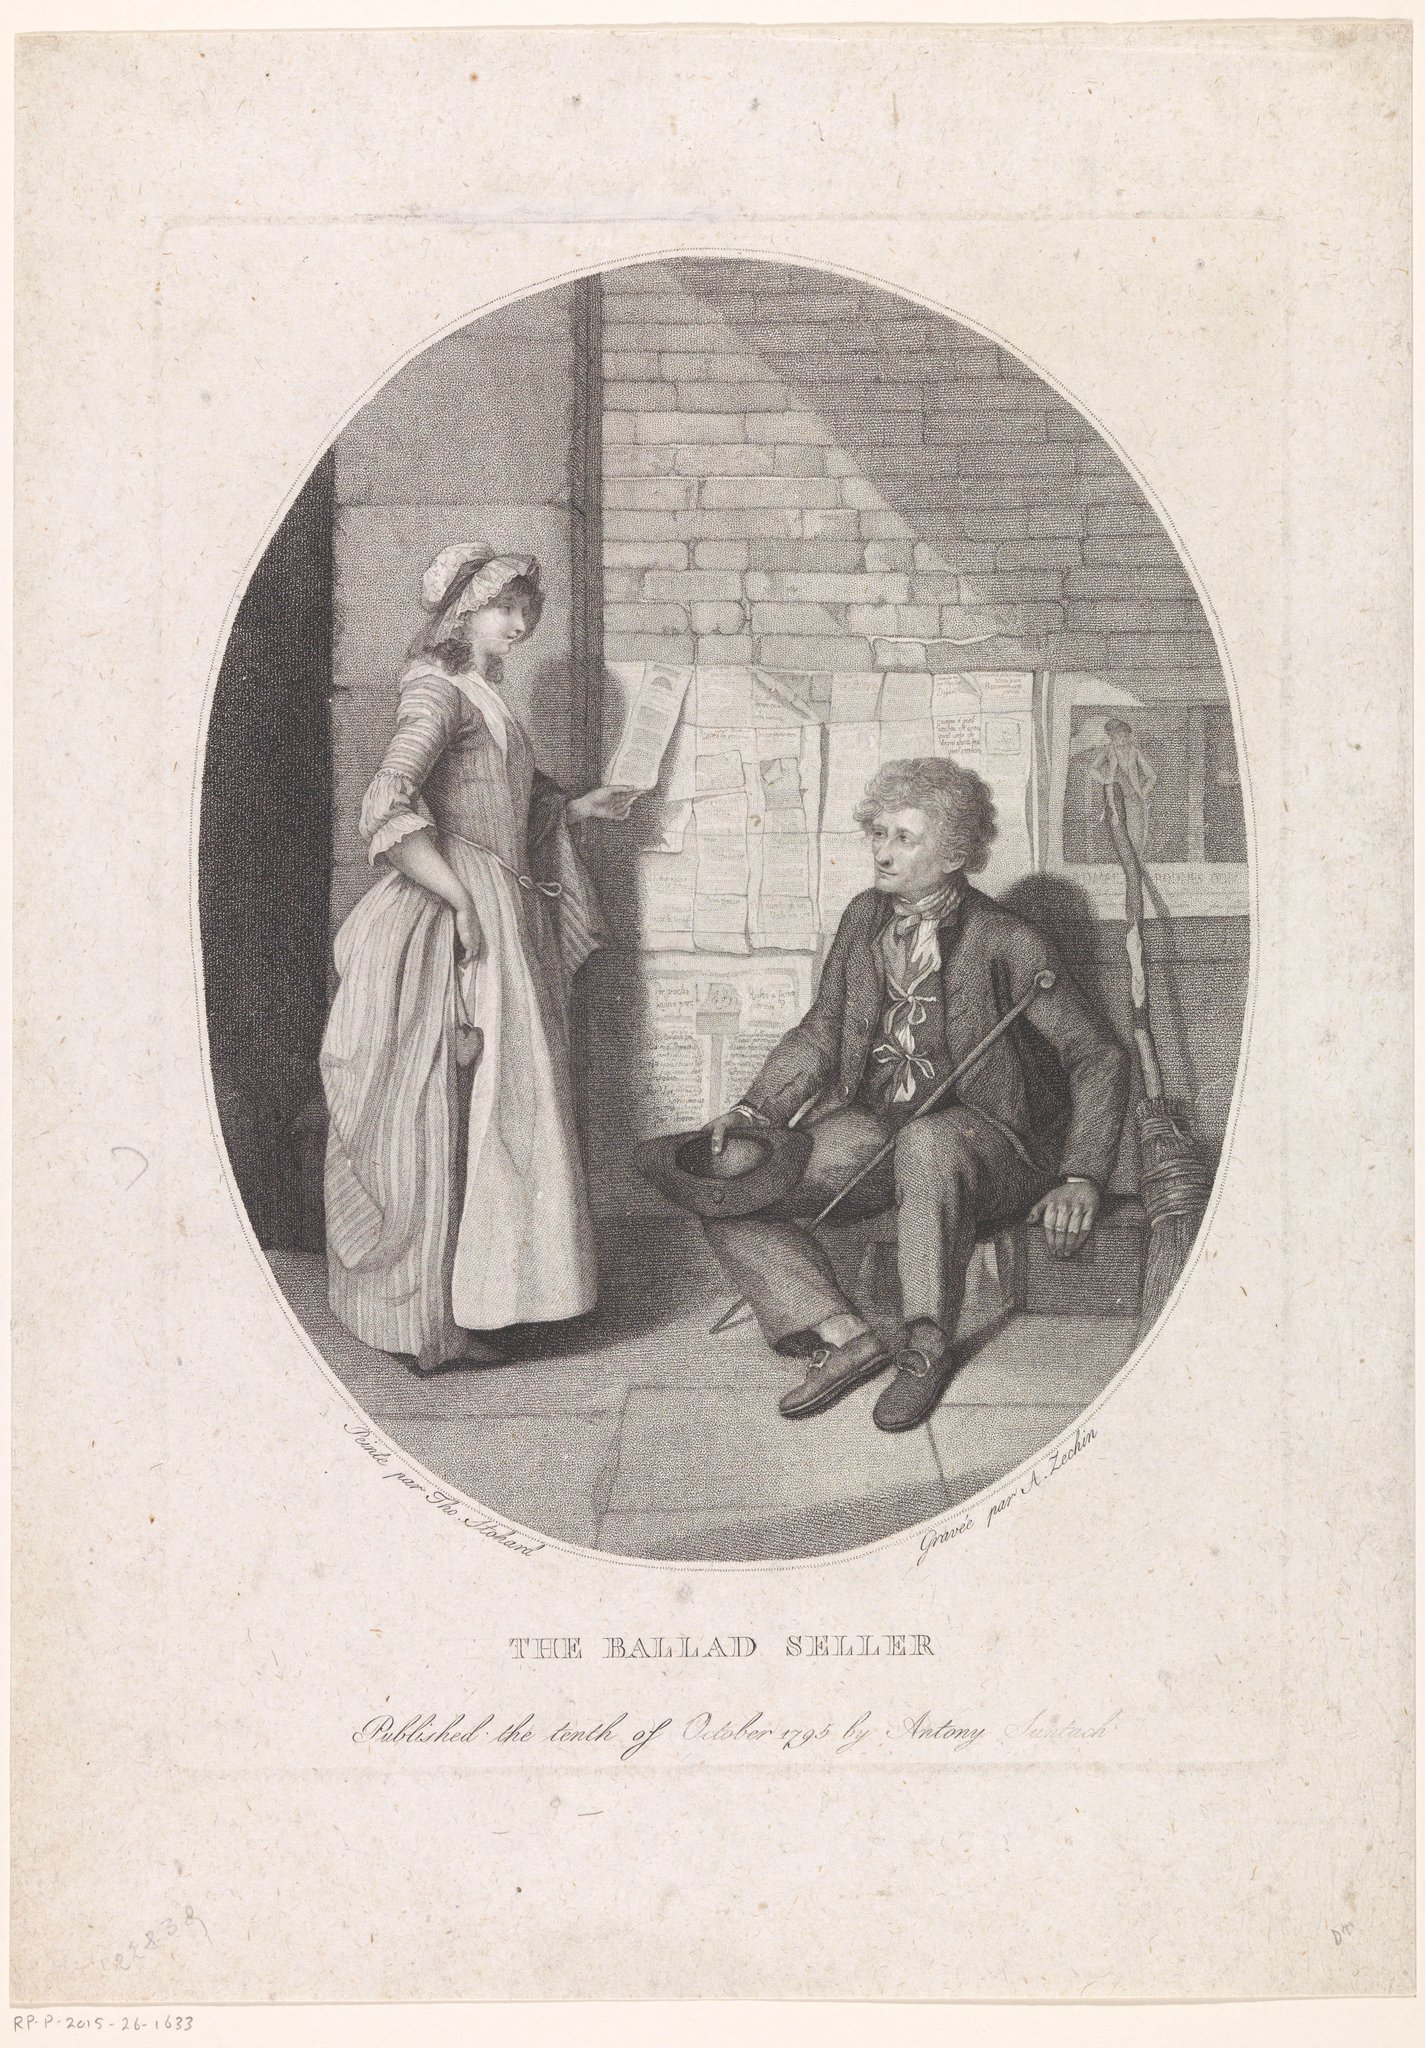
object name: print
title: Jonge vrouw en een liedverkoper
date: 1795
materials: paper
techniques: etching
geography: venice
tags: street-trader, beggar, ballad singer, ballad seller - cc - out of doors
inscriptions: collector's mark: Lugt 2228, collector's mark: Lugt 4779, collector's mark: Lugt 4780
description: Op straat zit een liedverkoper met zijn hoed in zijn handen en een wandelstok tegen zijn been geleund. Achter hem hangt zijn voorraad liederen aan de muur. Een jonge vrouw bekijkt een van de liederen. Naast de liedverkoper leunt een bezem tegen een prent met een portret.